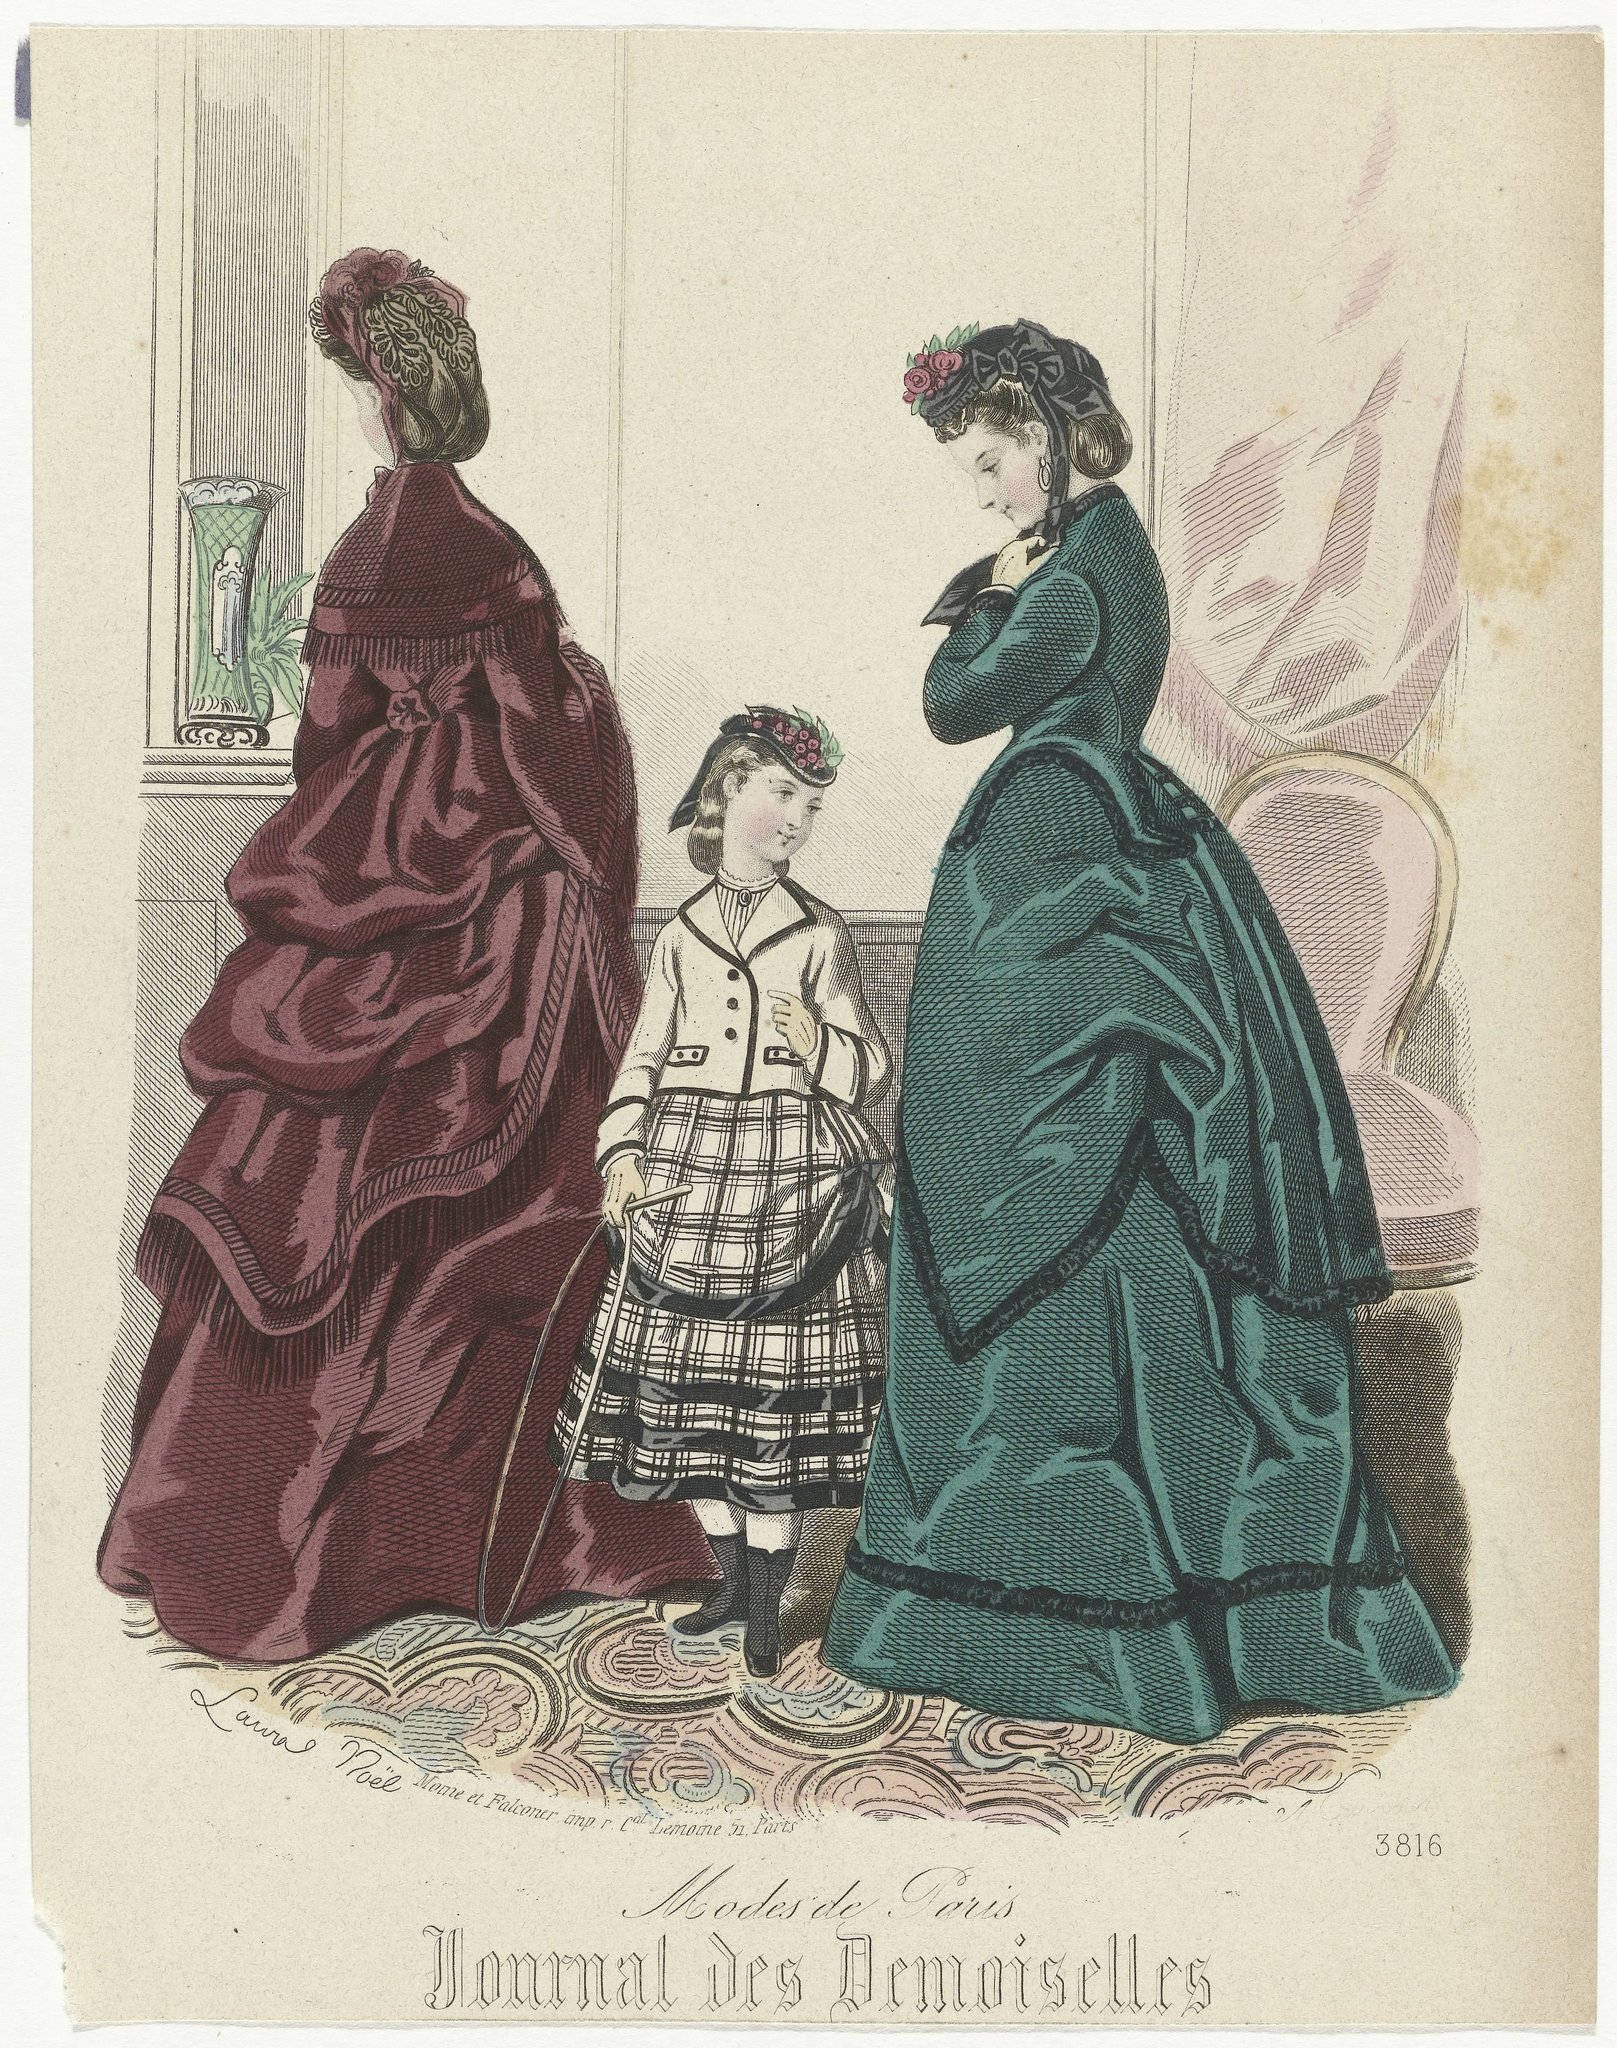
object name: fashion print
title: Journal des Demoiselles, 1871, No. 3816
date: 1871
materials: paper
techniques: engraving, hand coloring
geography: paris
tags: ear-rings (+ women's clothes), head-gear (+ girls' clothes), boots (+ girls' clothes), coat (+ women's clothes), coat (+ girls' clothes), head-gear (+ women's clothes), fashion plates, skirt (+ women's clothes), dress, gown (+ women's clothes), (bowling a) hoop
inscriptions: title: ‘Modes de Paris / Journal des Demoiselles’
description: Twee vrouwen en een meisje in een interieur. De linker vrouw, op de rug gezien is gekleed in een japon met mantel en een pelerine, afgezet met franjes. De andere vrouw draagt een jasje met lange mouwen en een rok. Het meisje is gekleed in een kort jasje op een geruite rok, waaronder korte laarzen. Prent uit het modetijdschrift Journal des Demoiselles (1833 -1922).